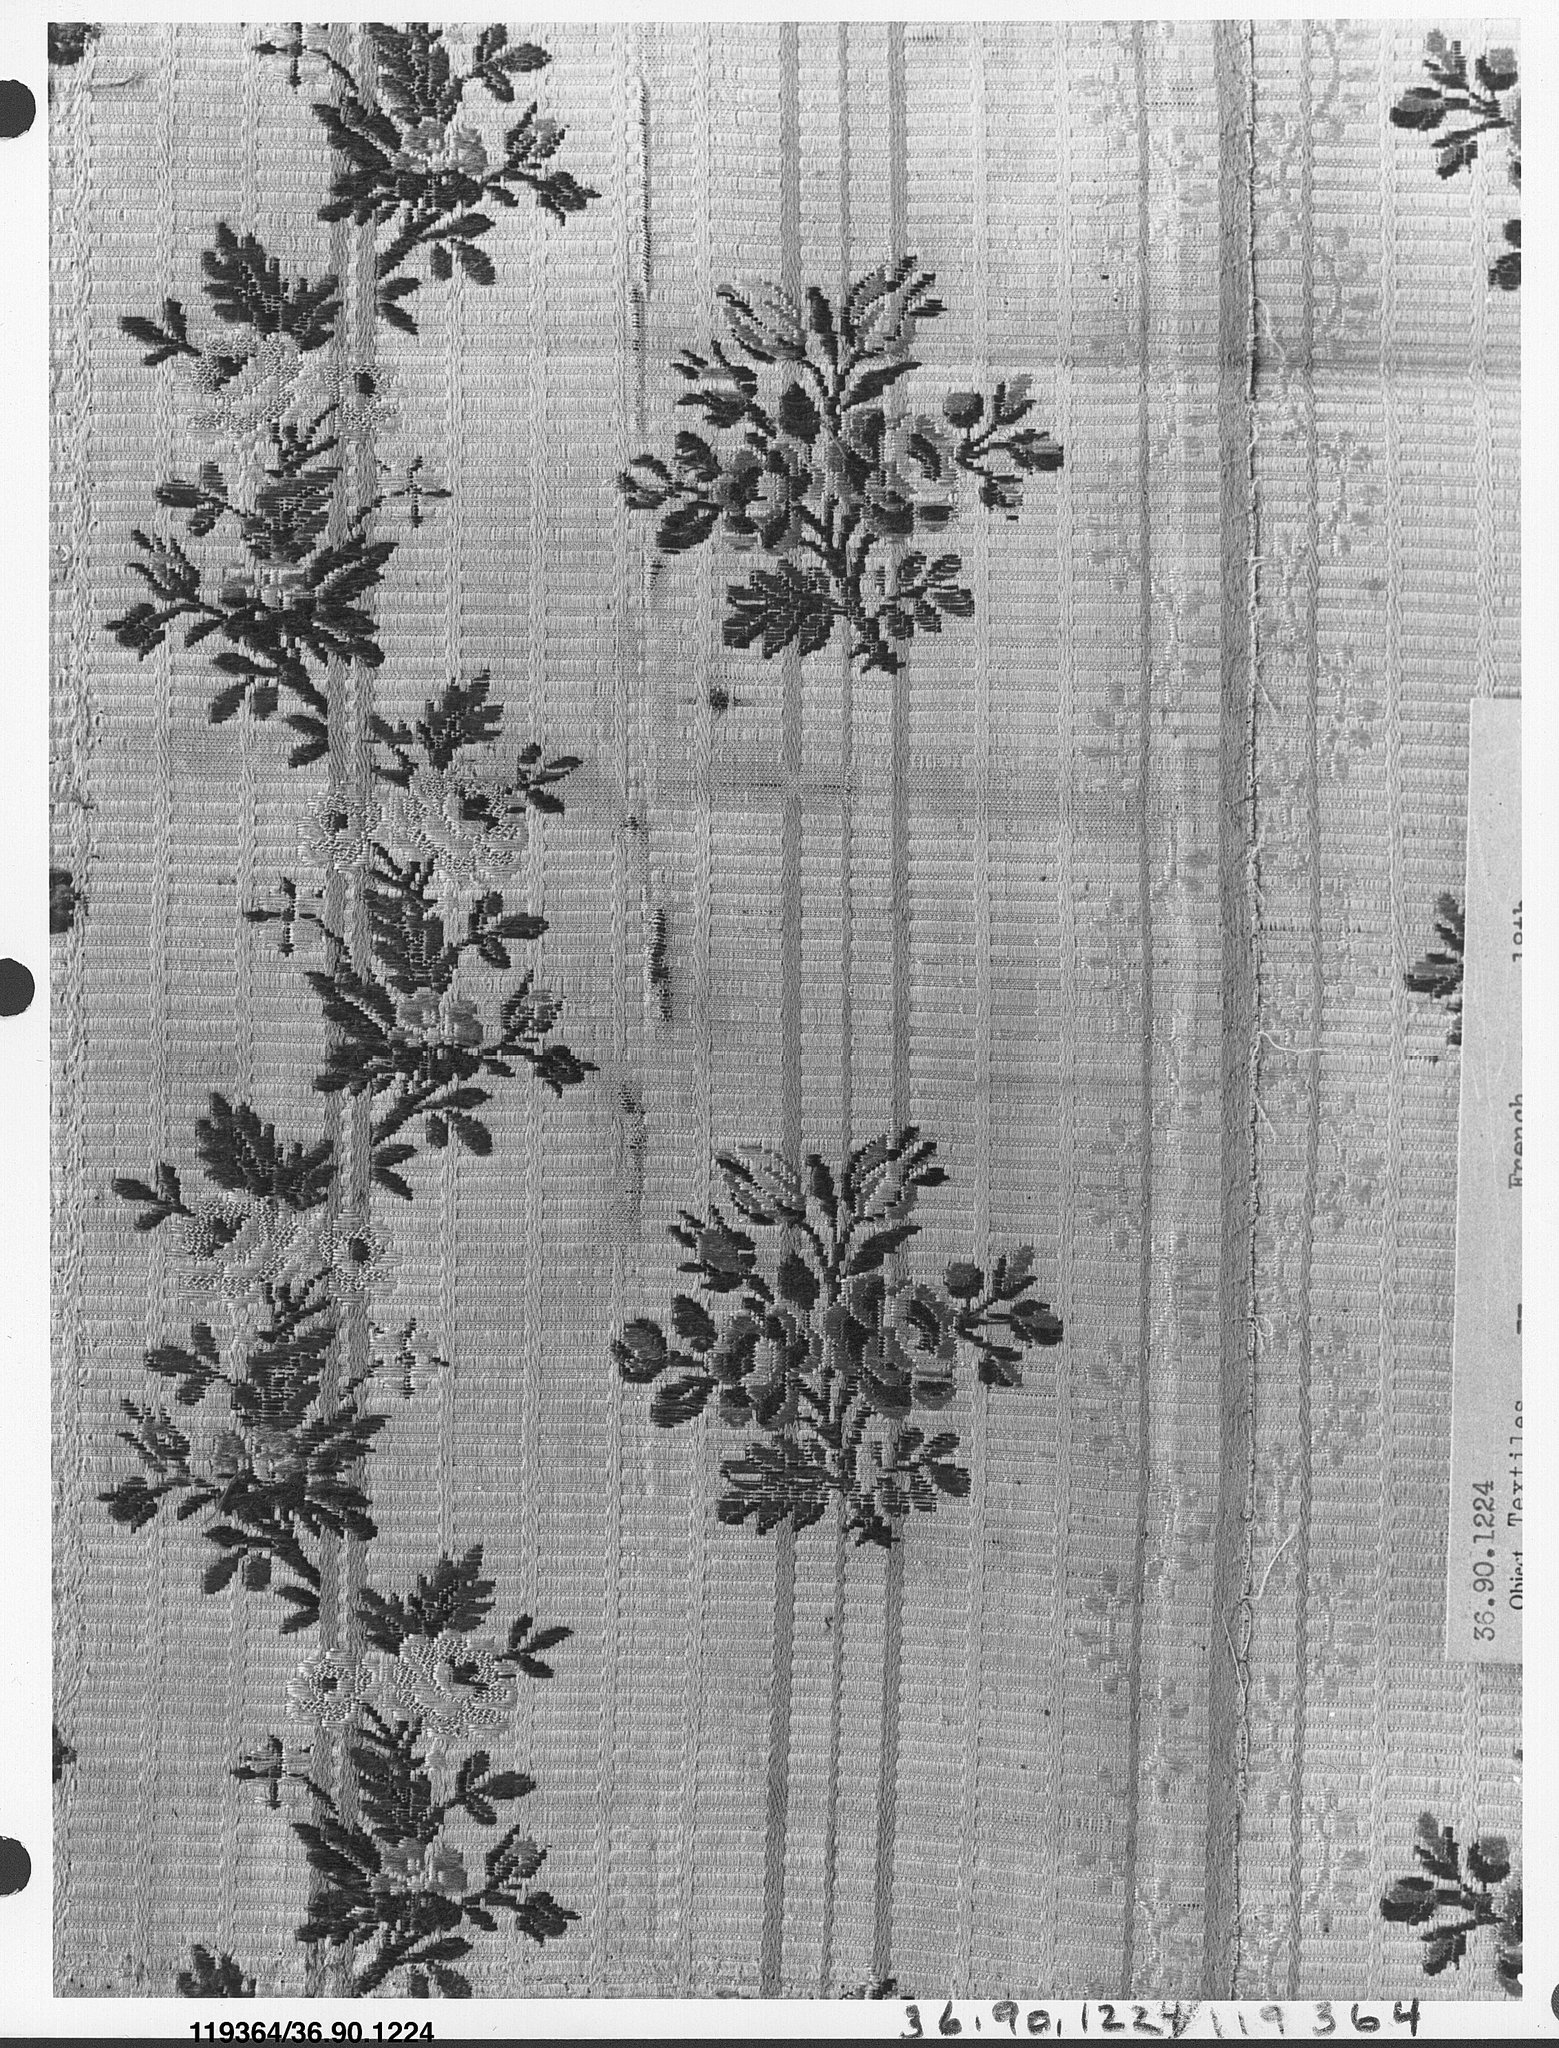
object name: piece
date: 1701-1800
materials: silk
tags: flowers,leaves